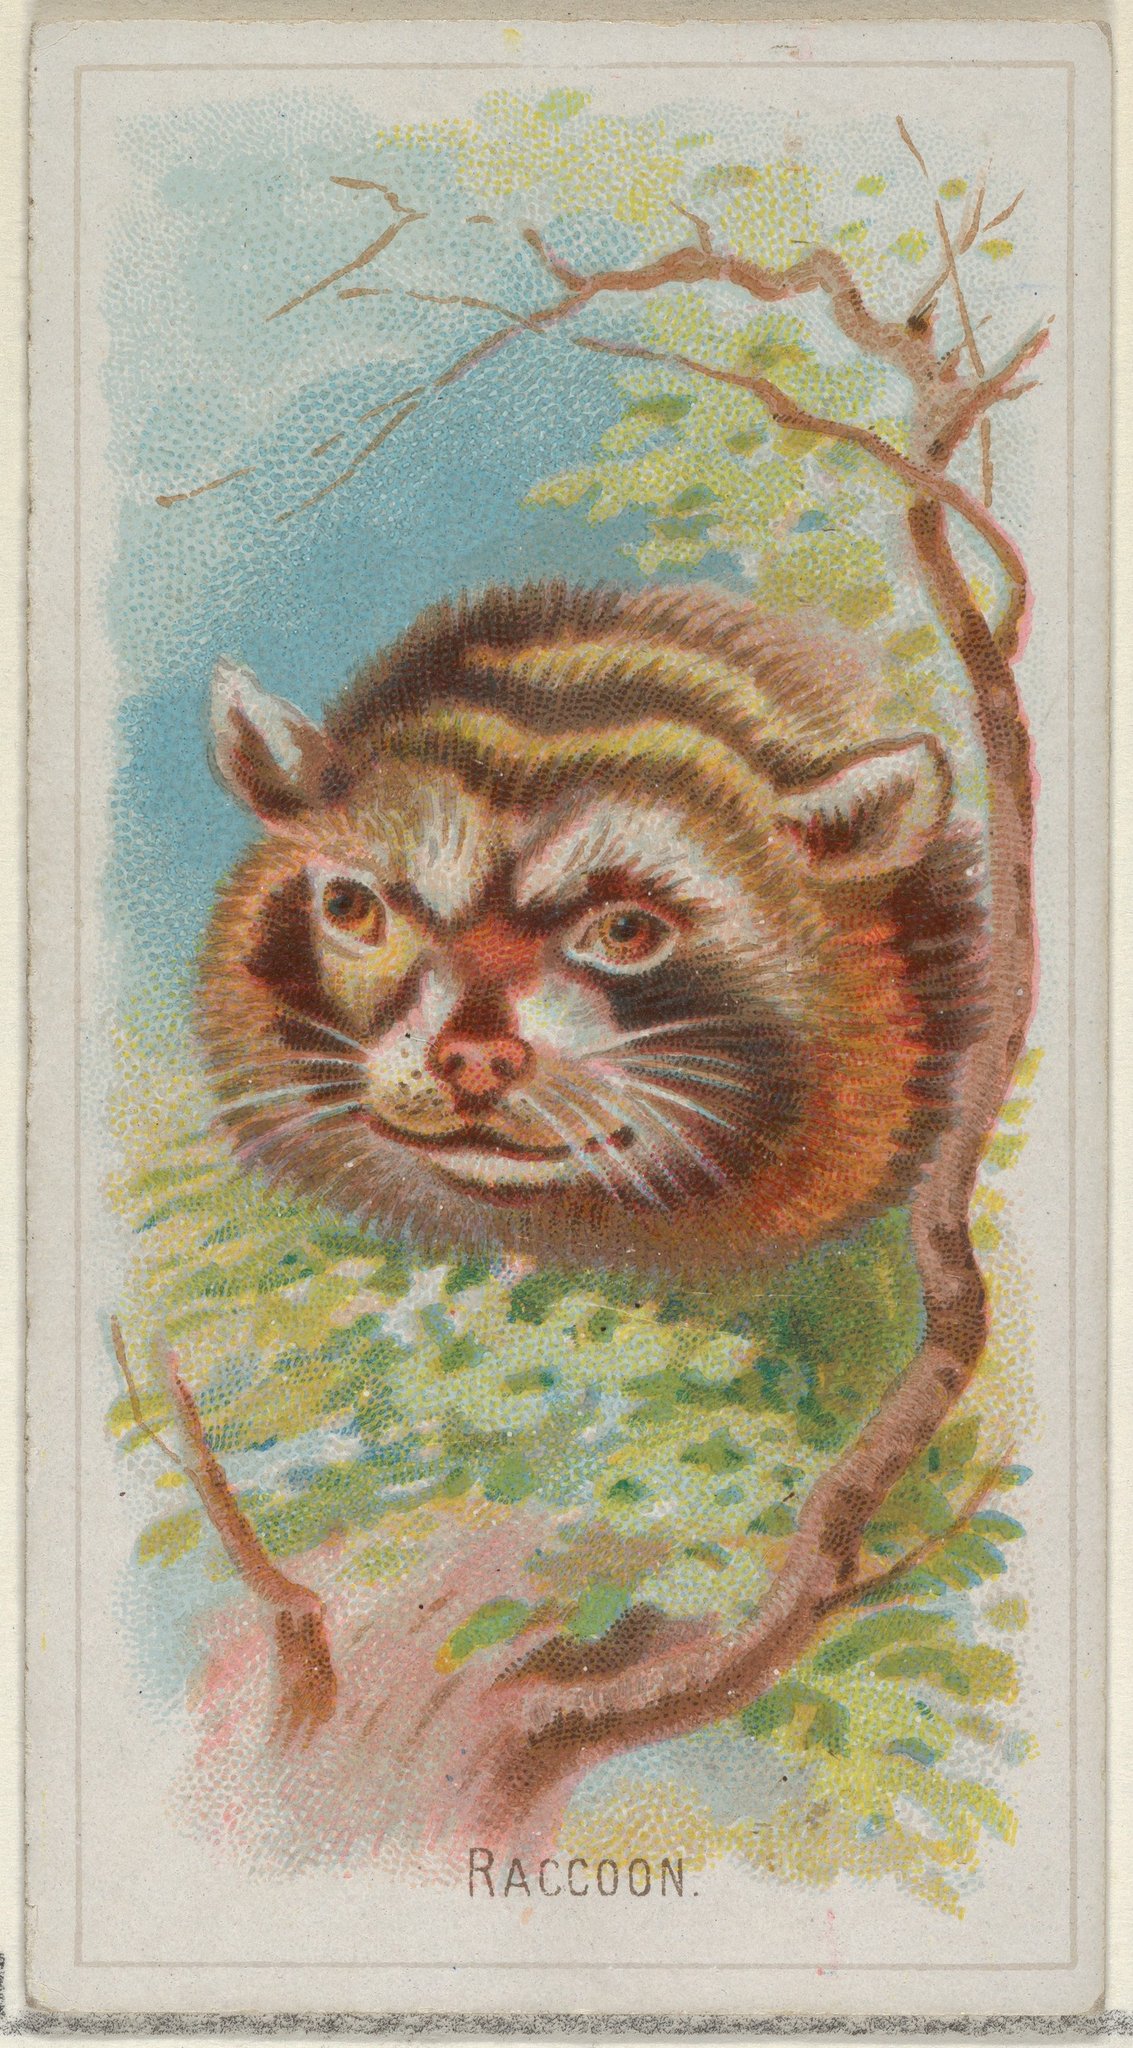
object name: print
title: Raccoon, from the Wild Animals of the World series (N25) for Allen & Ginter Cigarettes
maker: allen & ginter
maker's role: publisher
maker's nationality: american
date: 1888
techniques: color lithograph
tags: animals